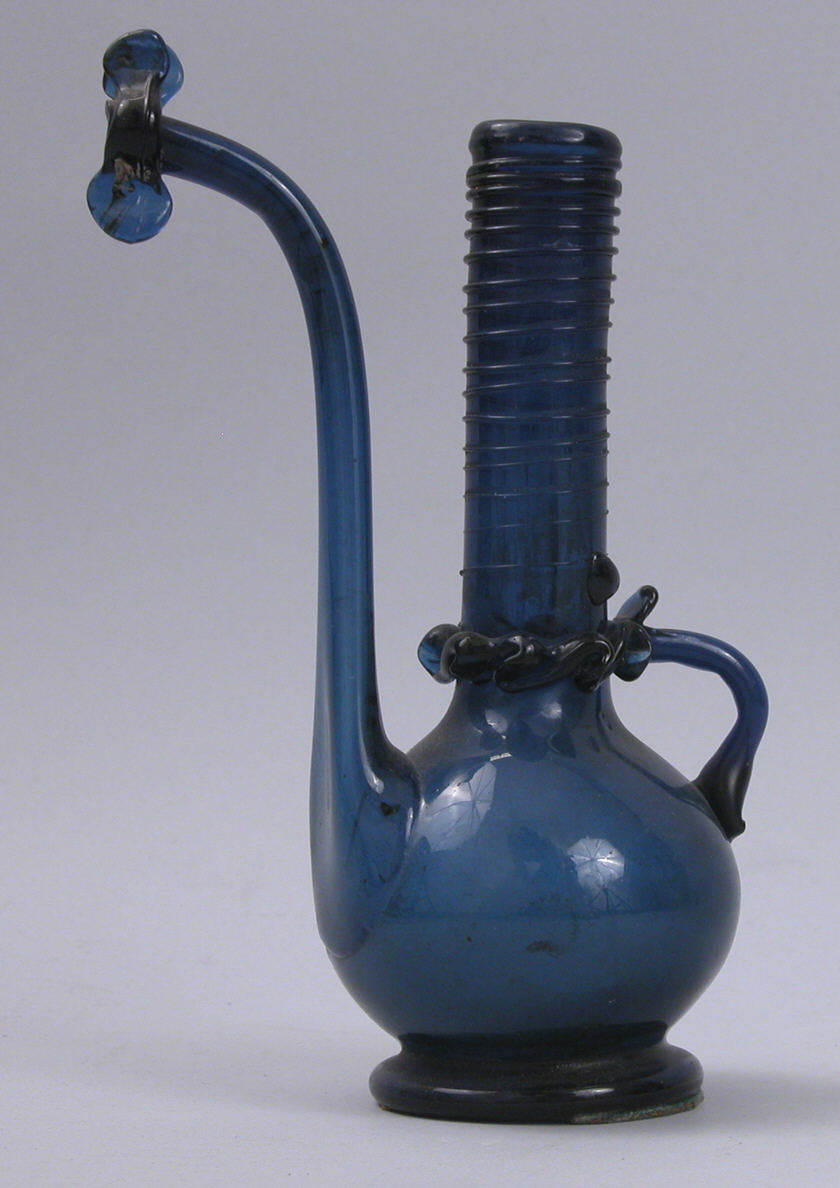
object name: ewer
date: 1701-1900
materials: glass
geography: iran